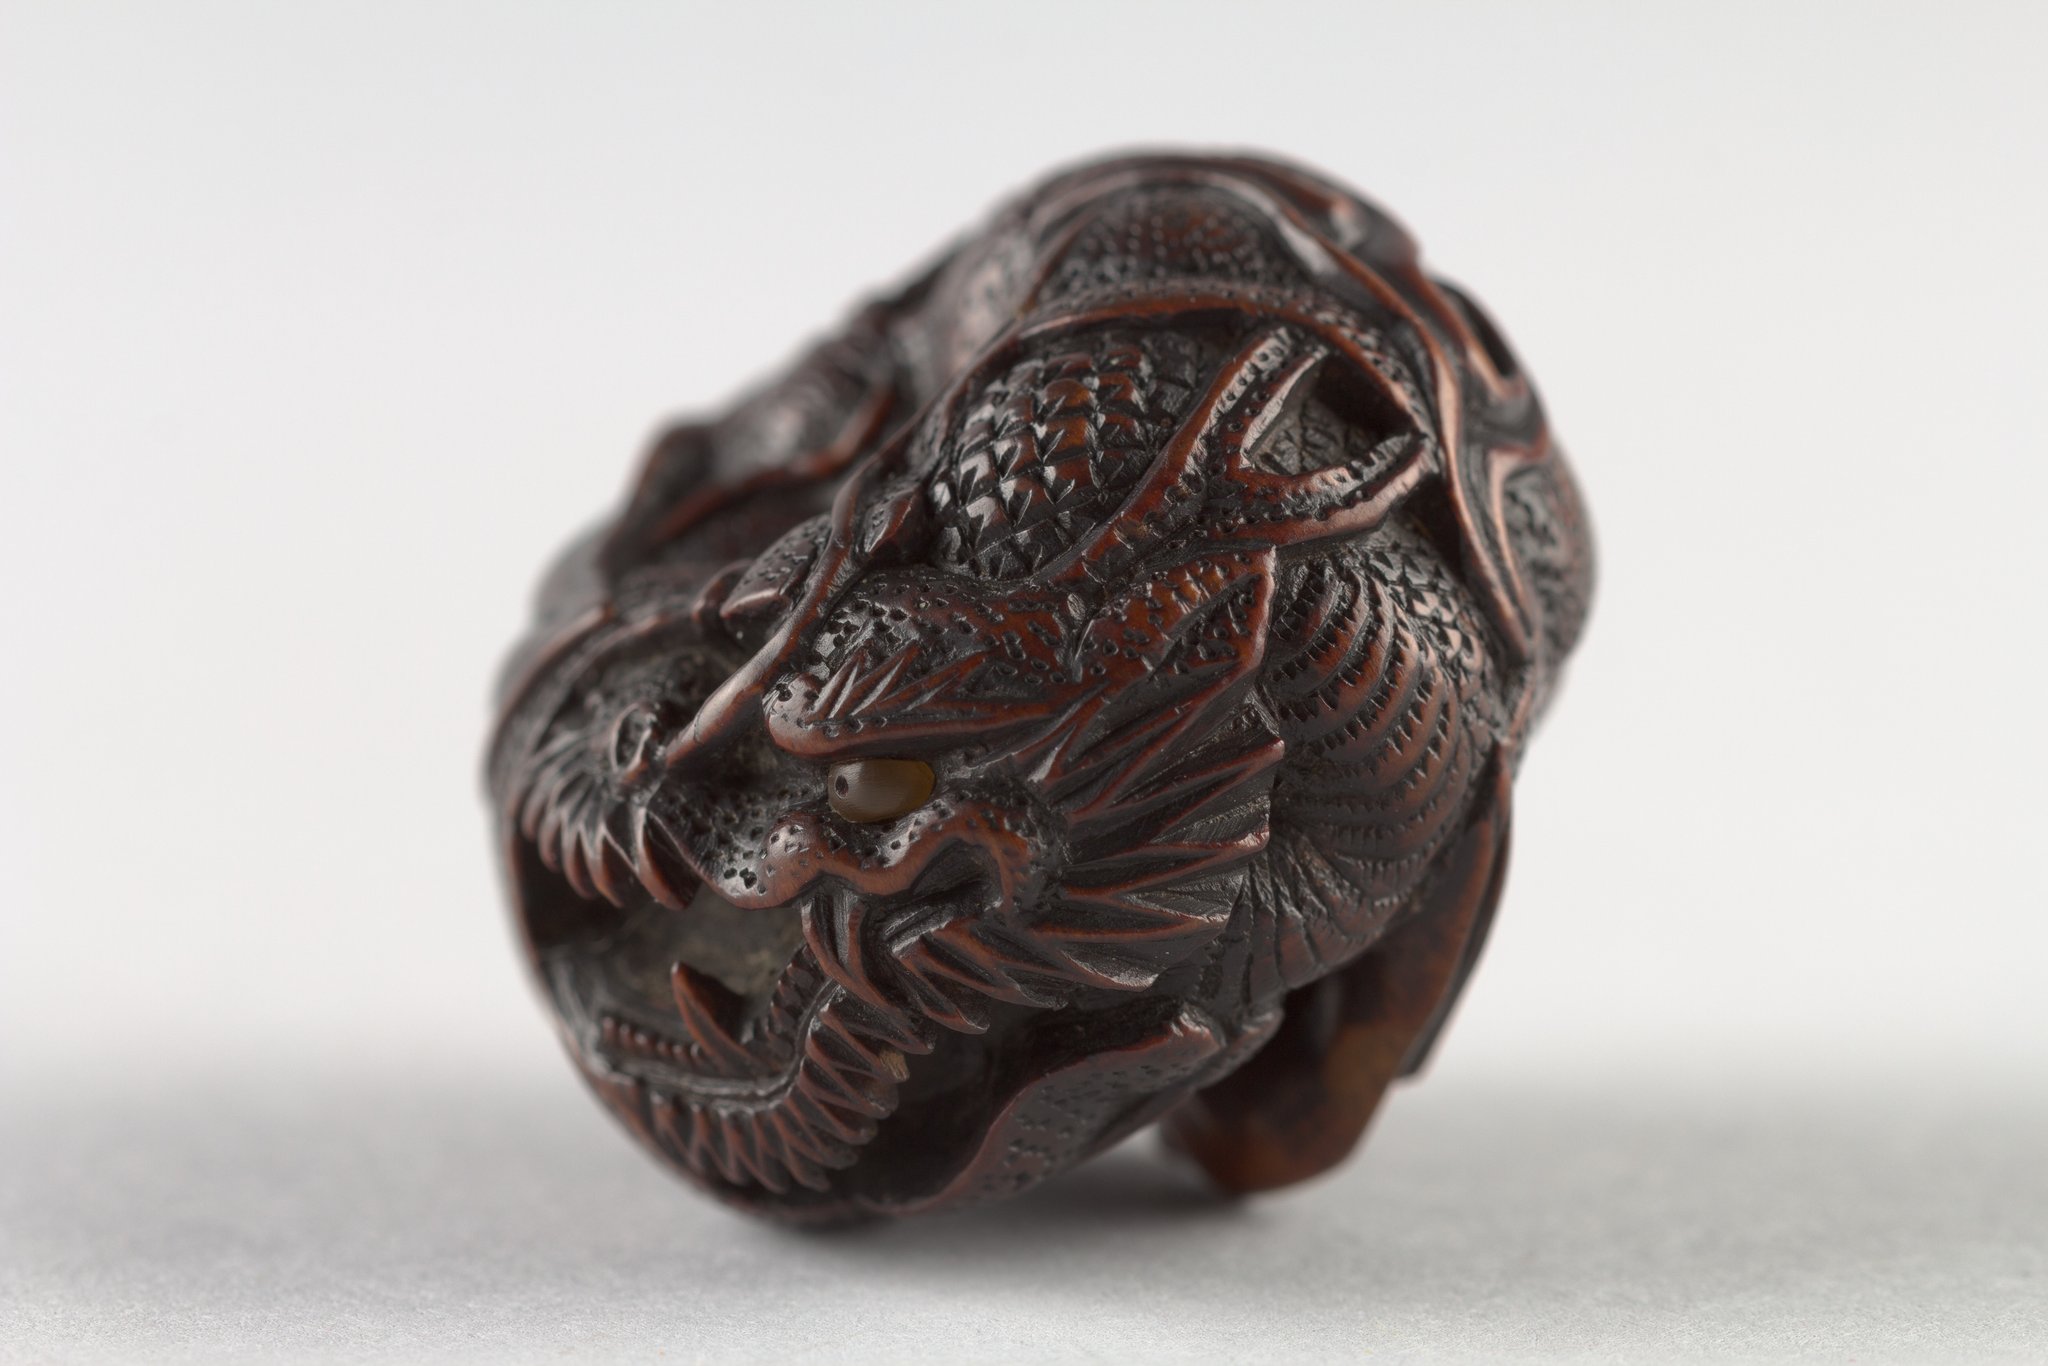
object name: netsuke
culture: japanese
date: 1701-1900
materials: wood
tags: dragons